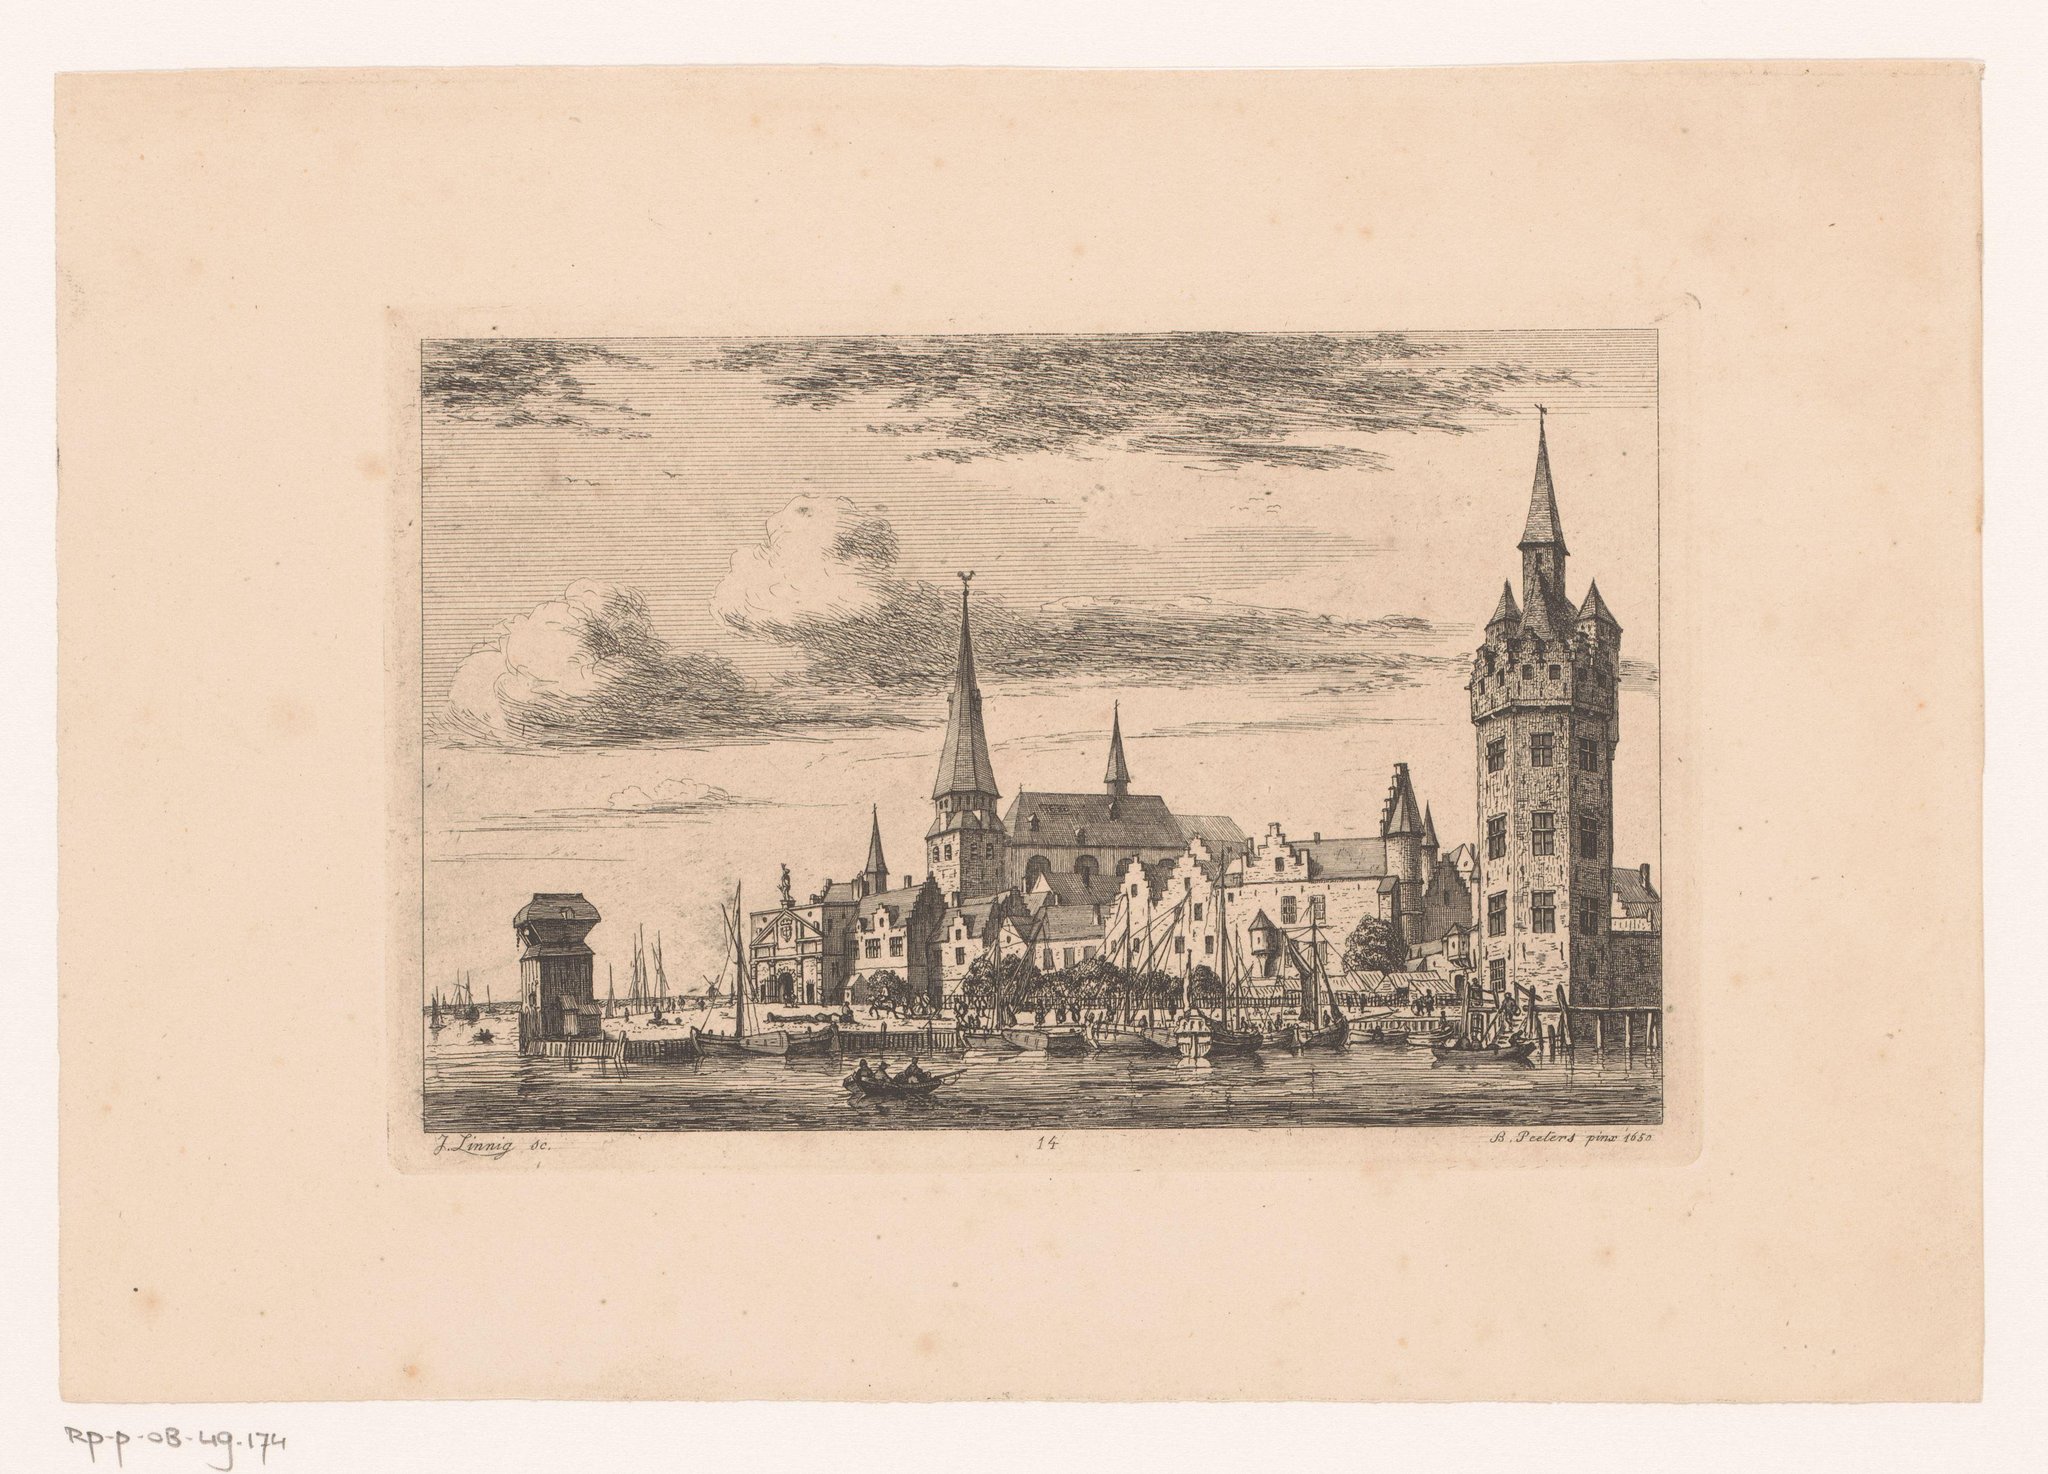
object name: print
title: Gezicht op de werf in Antwerpen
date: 1868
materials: paper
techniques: etching, intaglio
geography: antwerp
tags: pier, quay, wharf, quay, antwerp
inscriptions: collector's mark: Lugt 2228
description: Prent uit: Mertens, F.H. Album historique de la ville d'Anvers [...]. Antwerpen: J.E. Buschmann, 1868.